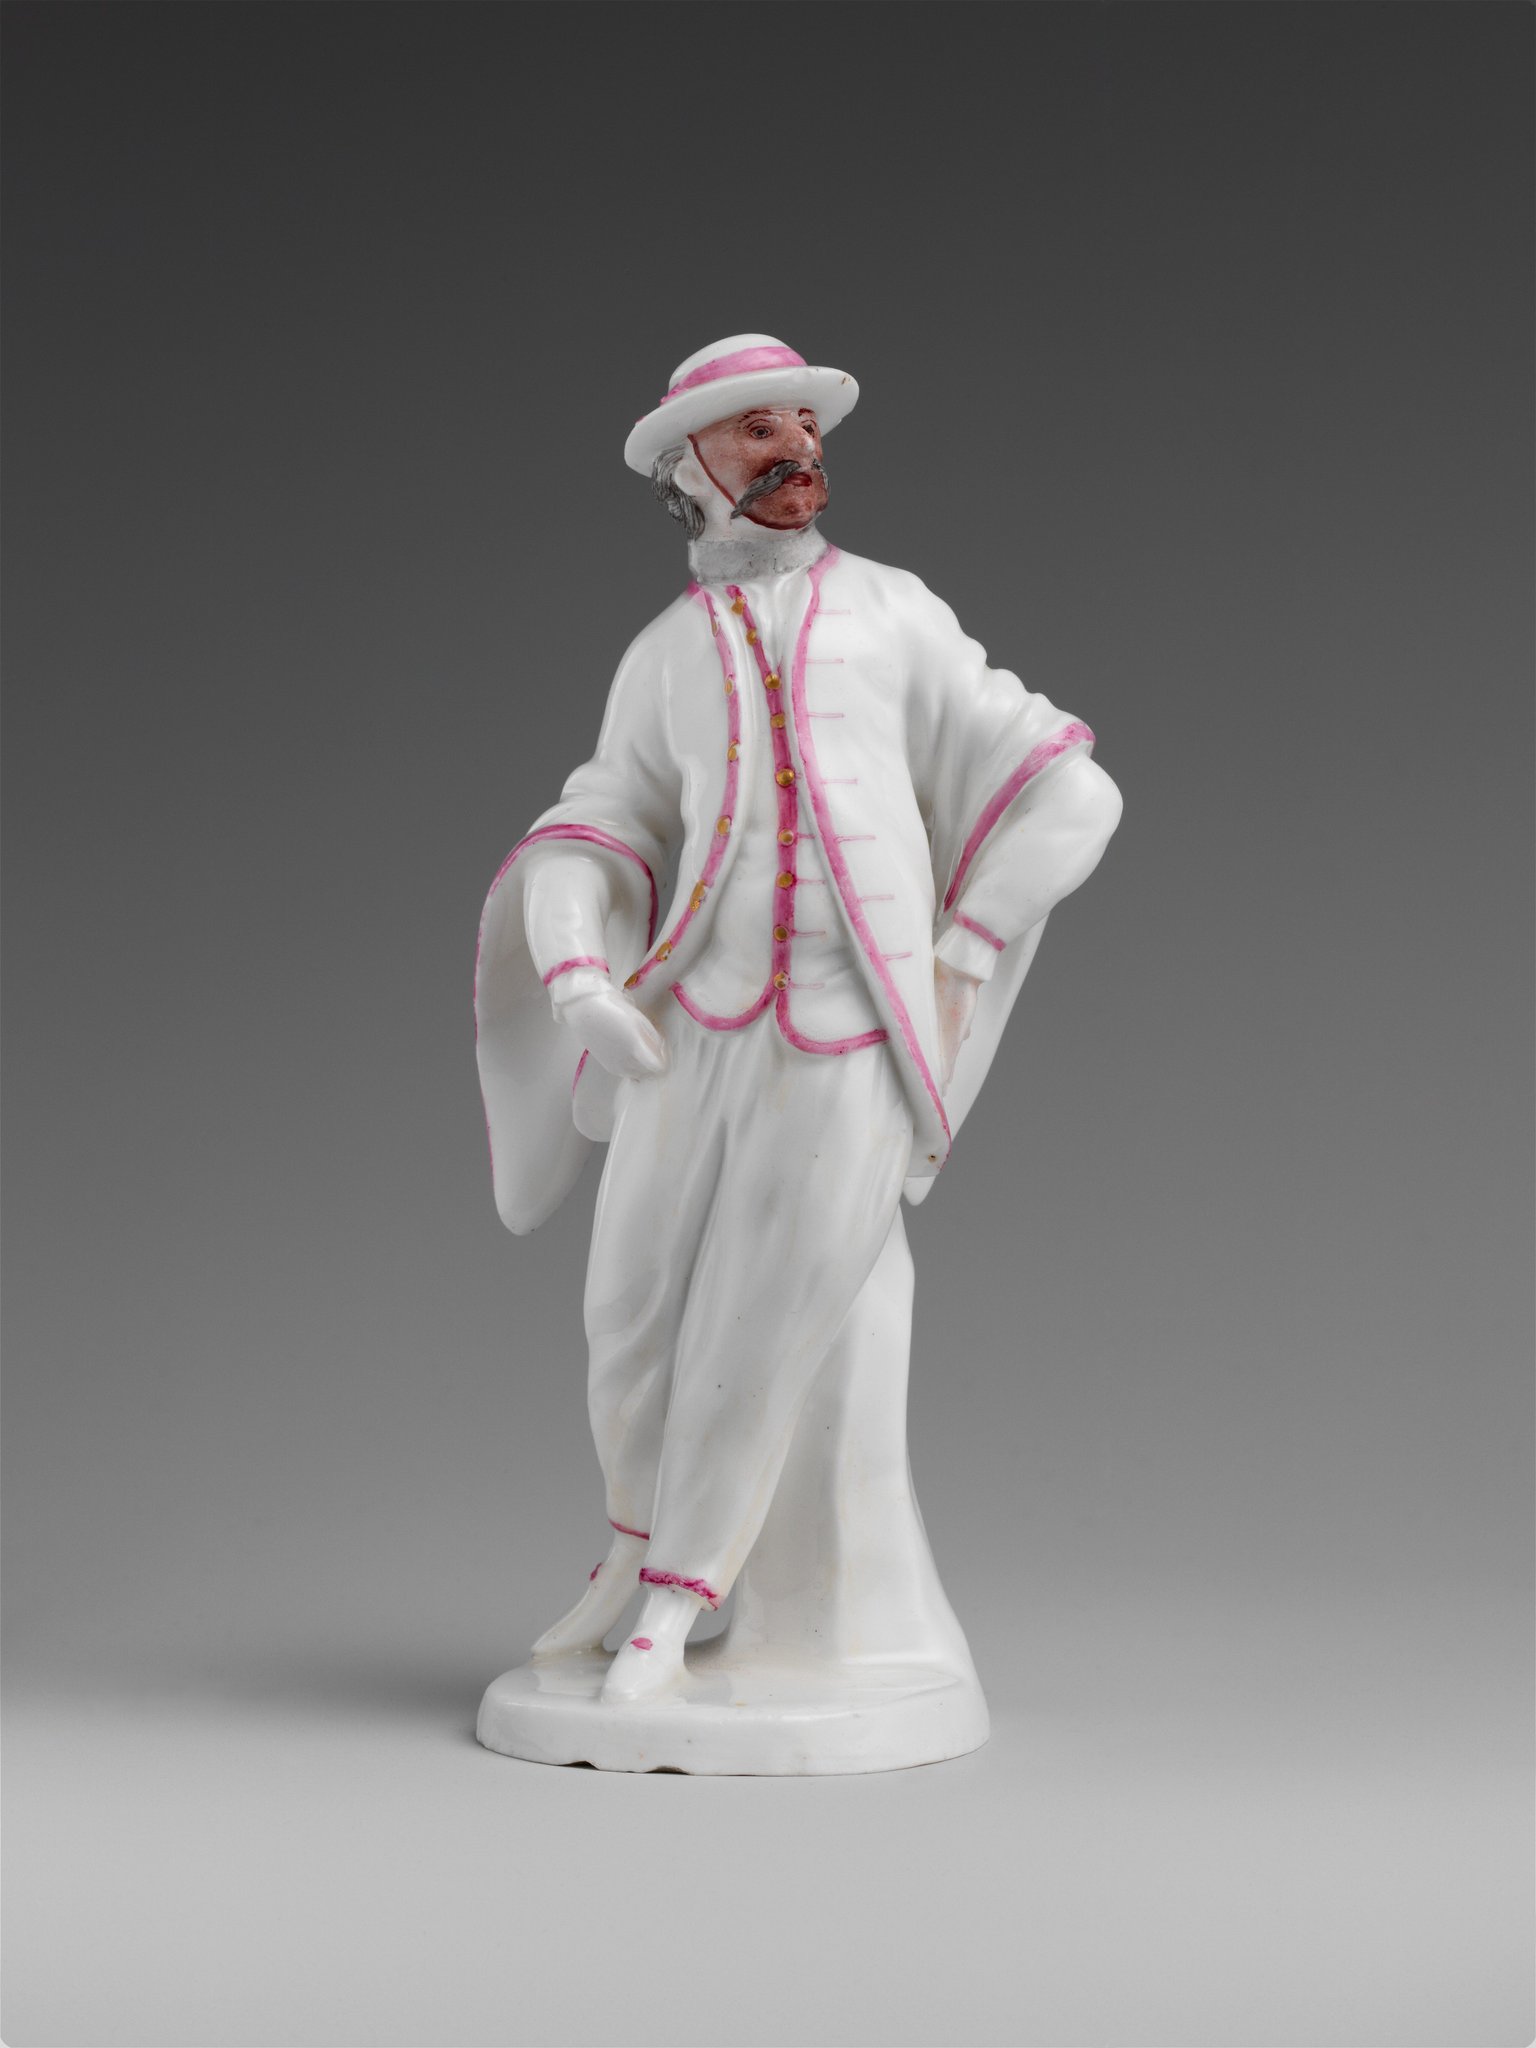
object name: figure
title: Masquerader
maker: zurich pottery and porcelain factory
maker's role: factory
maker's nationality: swiss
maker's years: 1763-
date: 1765-1770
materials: soft paste porcelain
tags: men